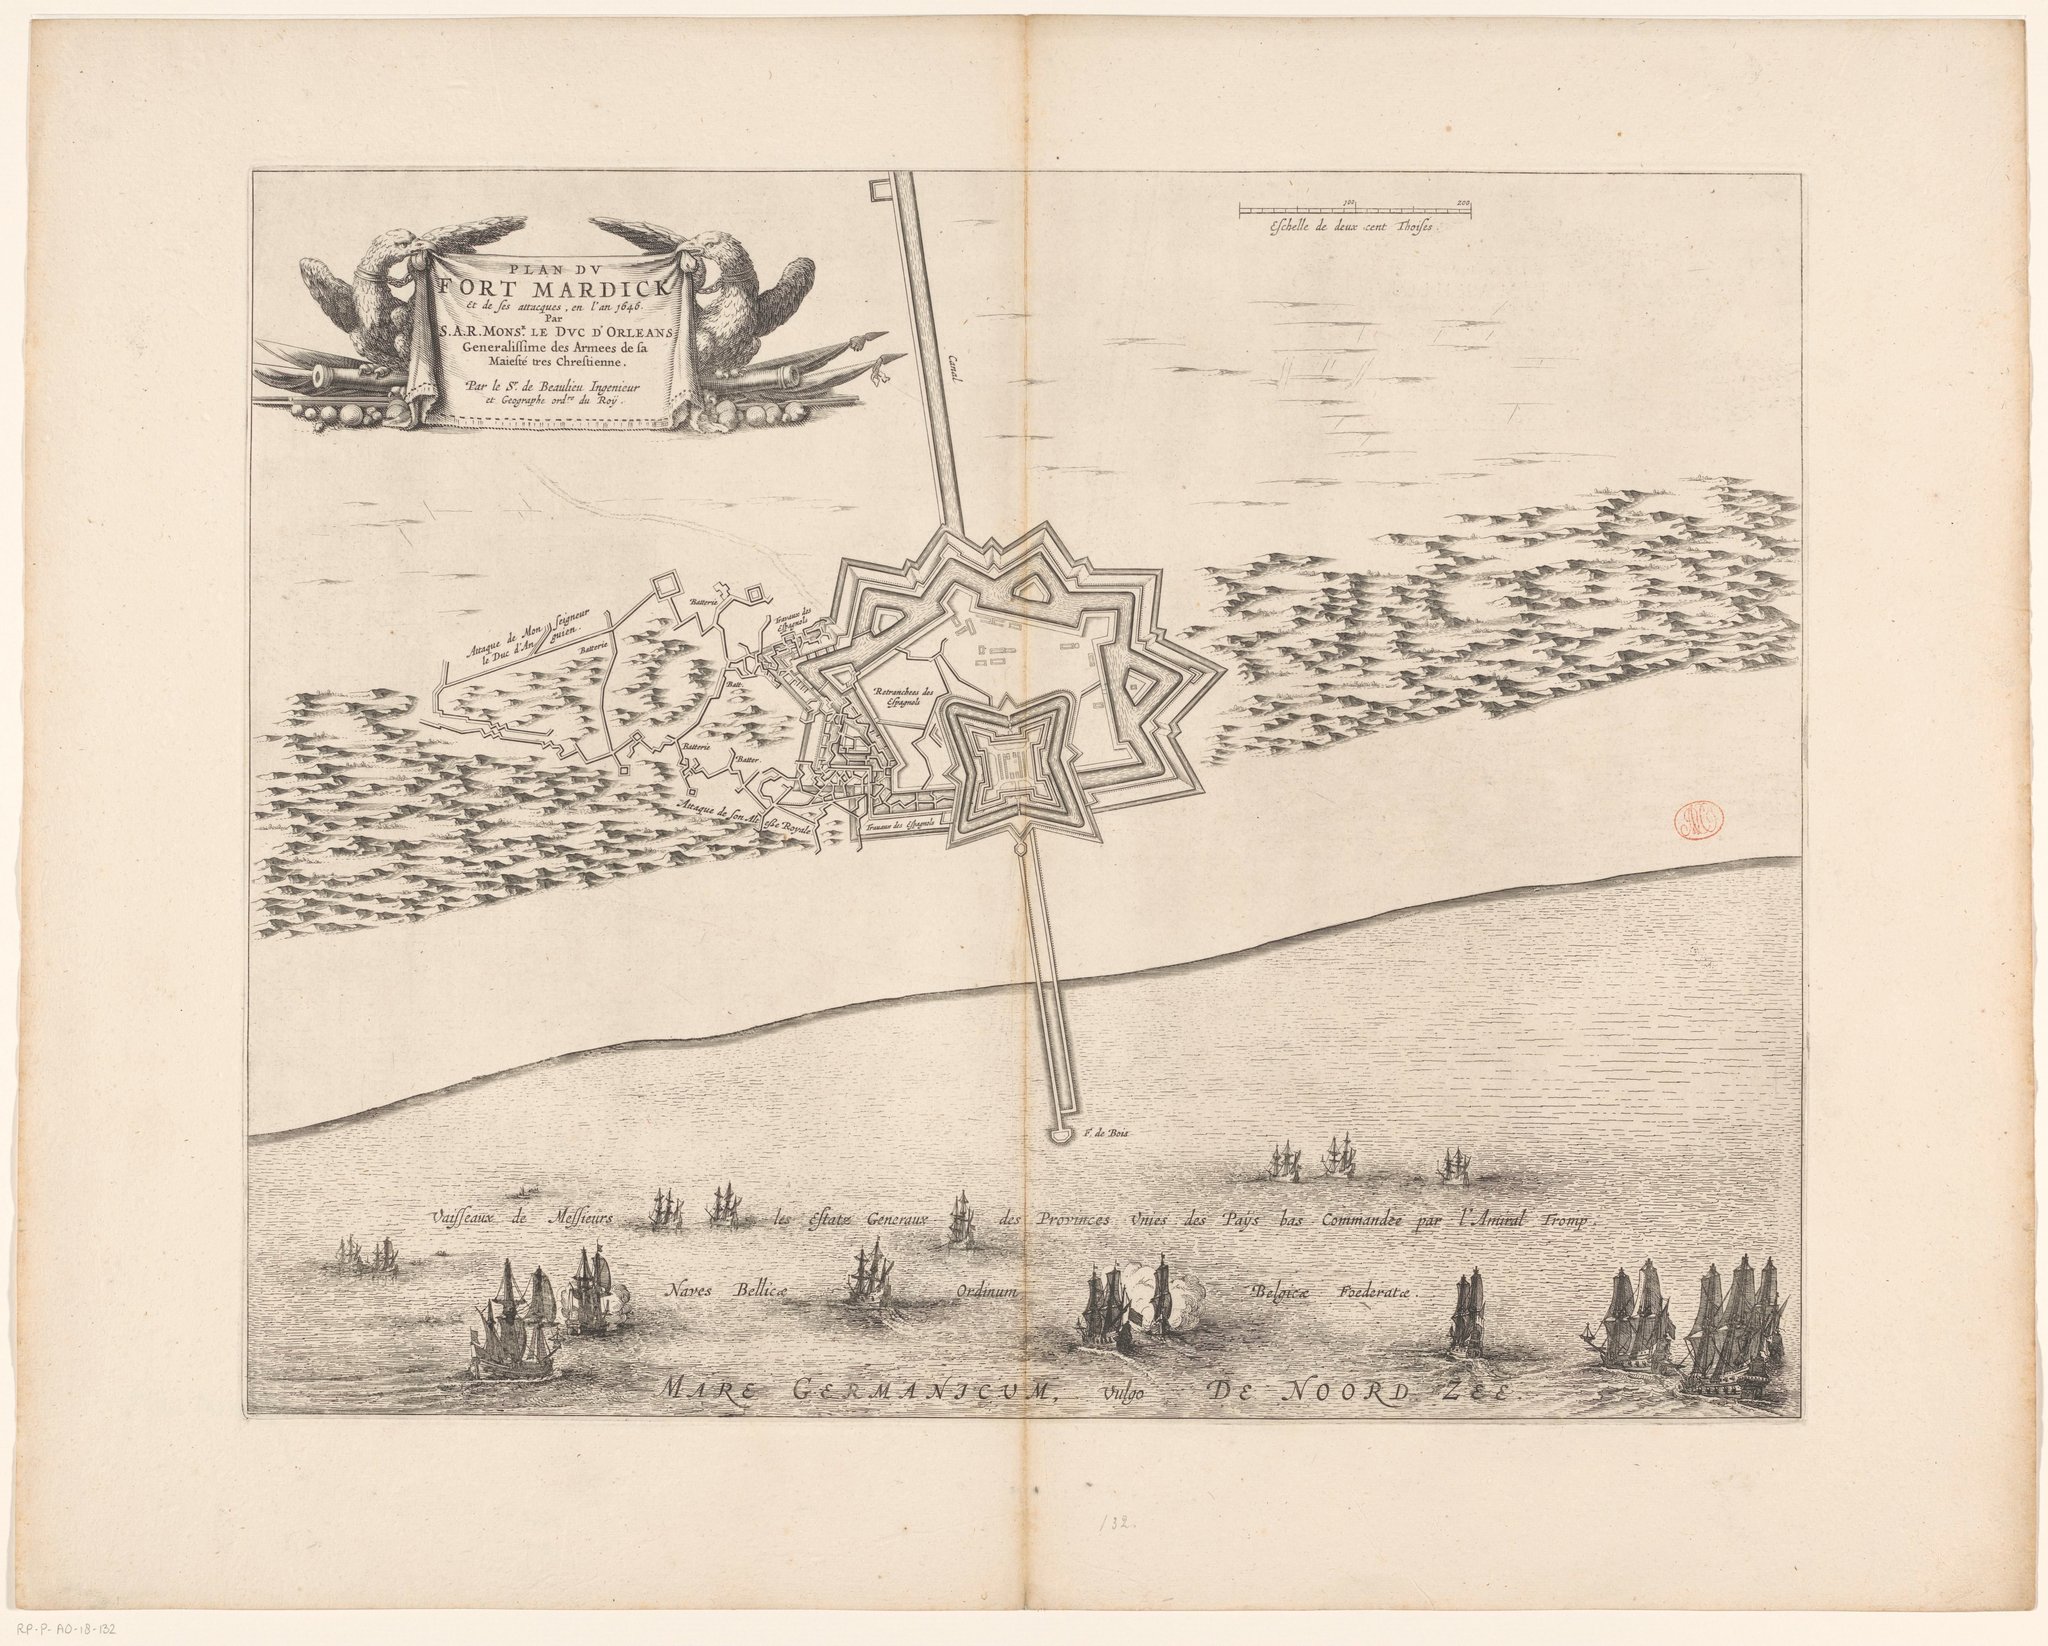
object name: print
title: Plan du Fort Mardick Et de ses attacques, en l'an 1646 par S.A.R. monsr. le duc d'Orleans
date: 1646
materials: paper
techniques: etching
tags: gaston jean-baptiste hertog van orléans, brielle, maarten harpertszoon tromp, siege, position war, maps of cities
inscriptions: collector's mark: Lugt 2228, collector's mark: Lugt 195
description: Onderdeel van een serie voorstellingen van de militaire overwinningen behaald door koning Lodewijk XIV: Les Glorieuses conquêtes de Louis le Grand, d'après le chevalier de Beaulieu. Volgens Muller en Van Rijn is dit een omgekeerde kopie naar de prent in de Atlas van Stolk (nr. 1917), ook volgens hen gebruikt in het Stedenboek van Blaeu, maar niet vermeld in Koeman.